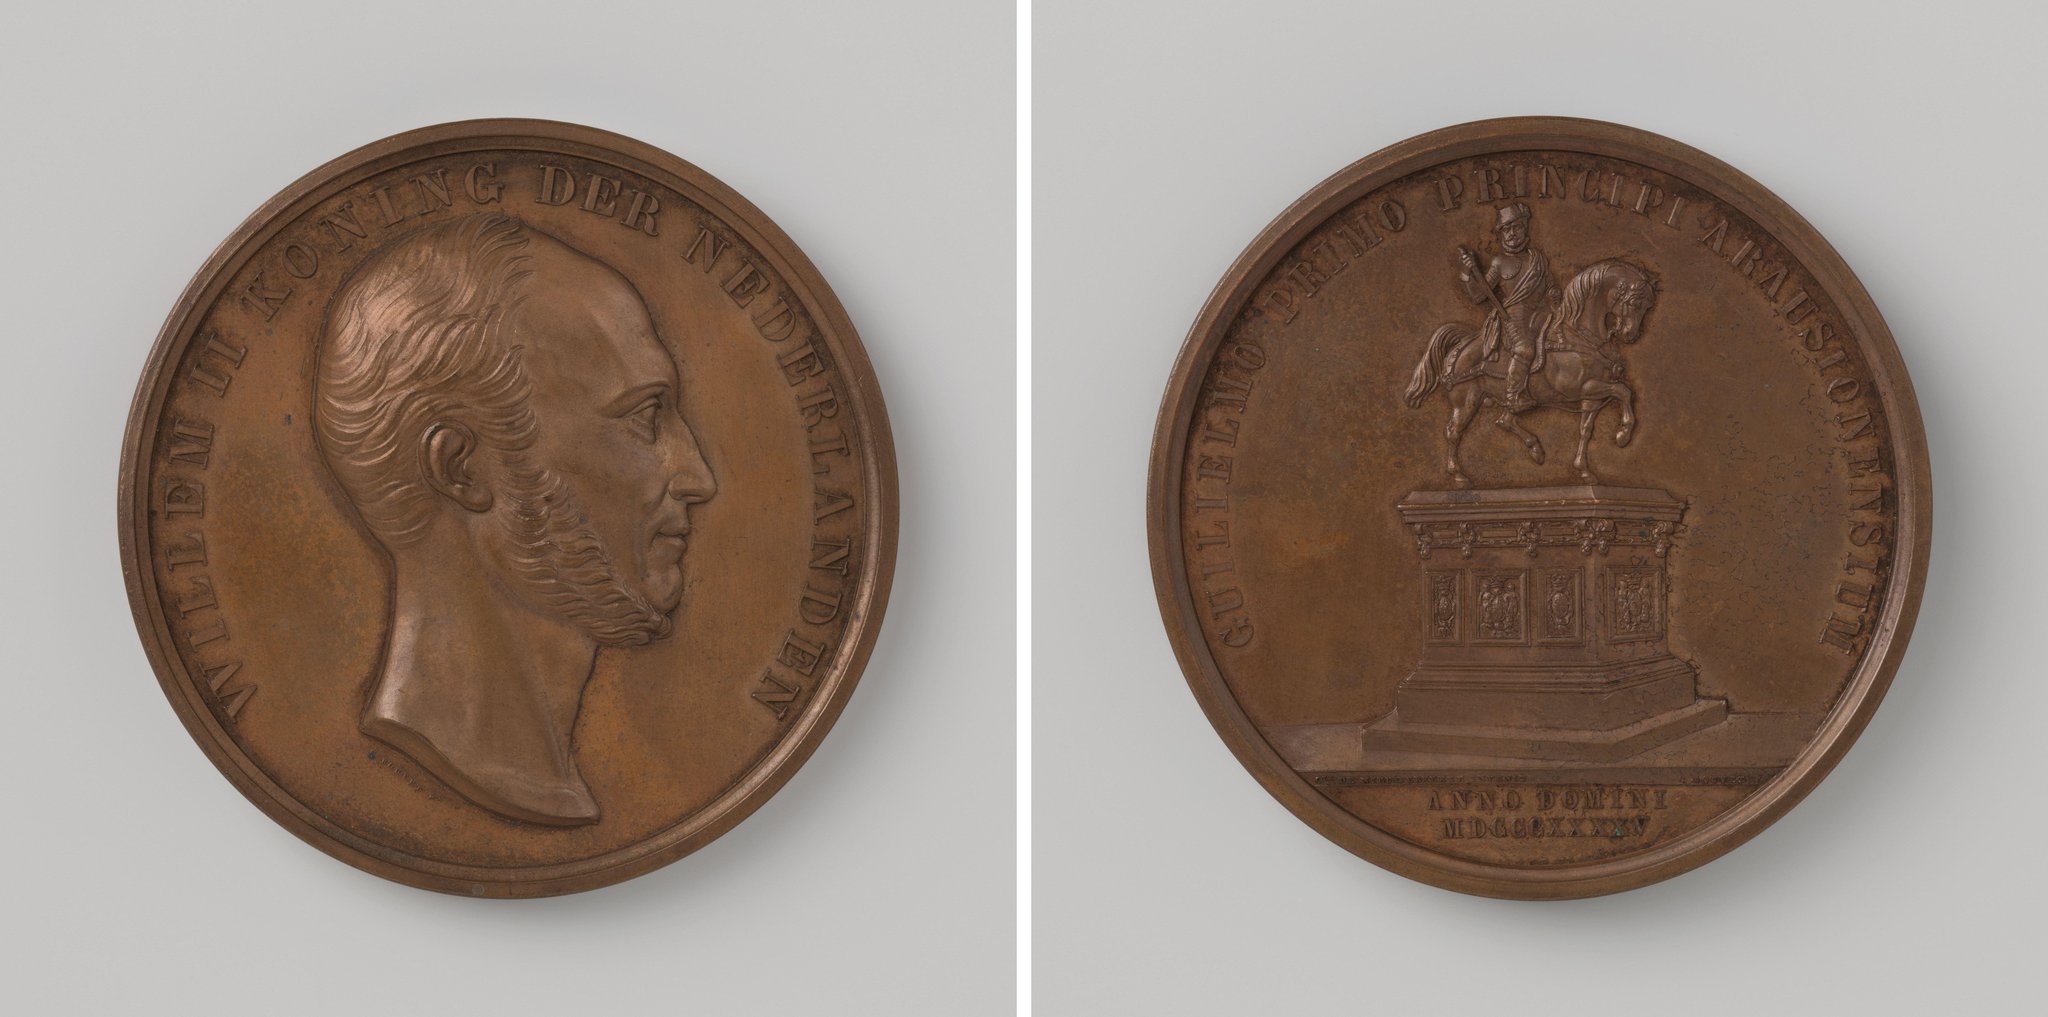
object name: history medal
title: Oprichting van het ruiterstandbeeld van Willem van Oranje in Den Haag 1845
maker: c. bouvet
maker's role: die cutter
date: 1845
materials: bronze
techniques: striking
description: Forse bronzen penning, op de voorzijde het portret van Koning Willem II naar rechts met omschrift, op de keerzijde het ruiterstandbeeld half van rechts, met omschrift en afsnedetekst.